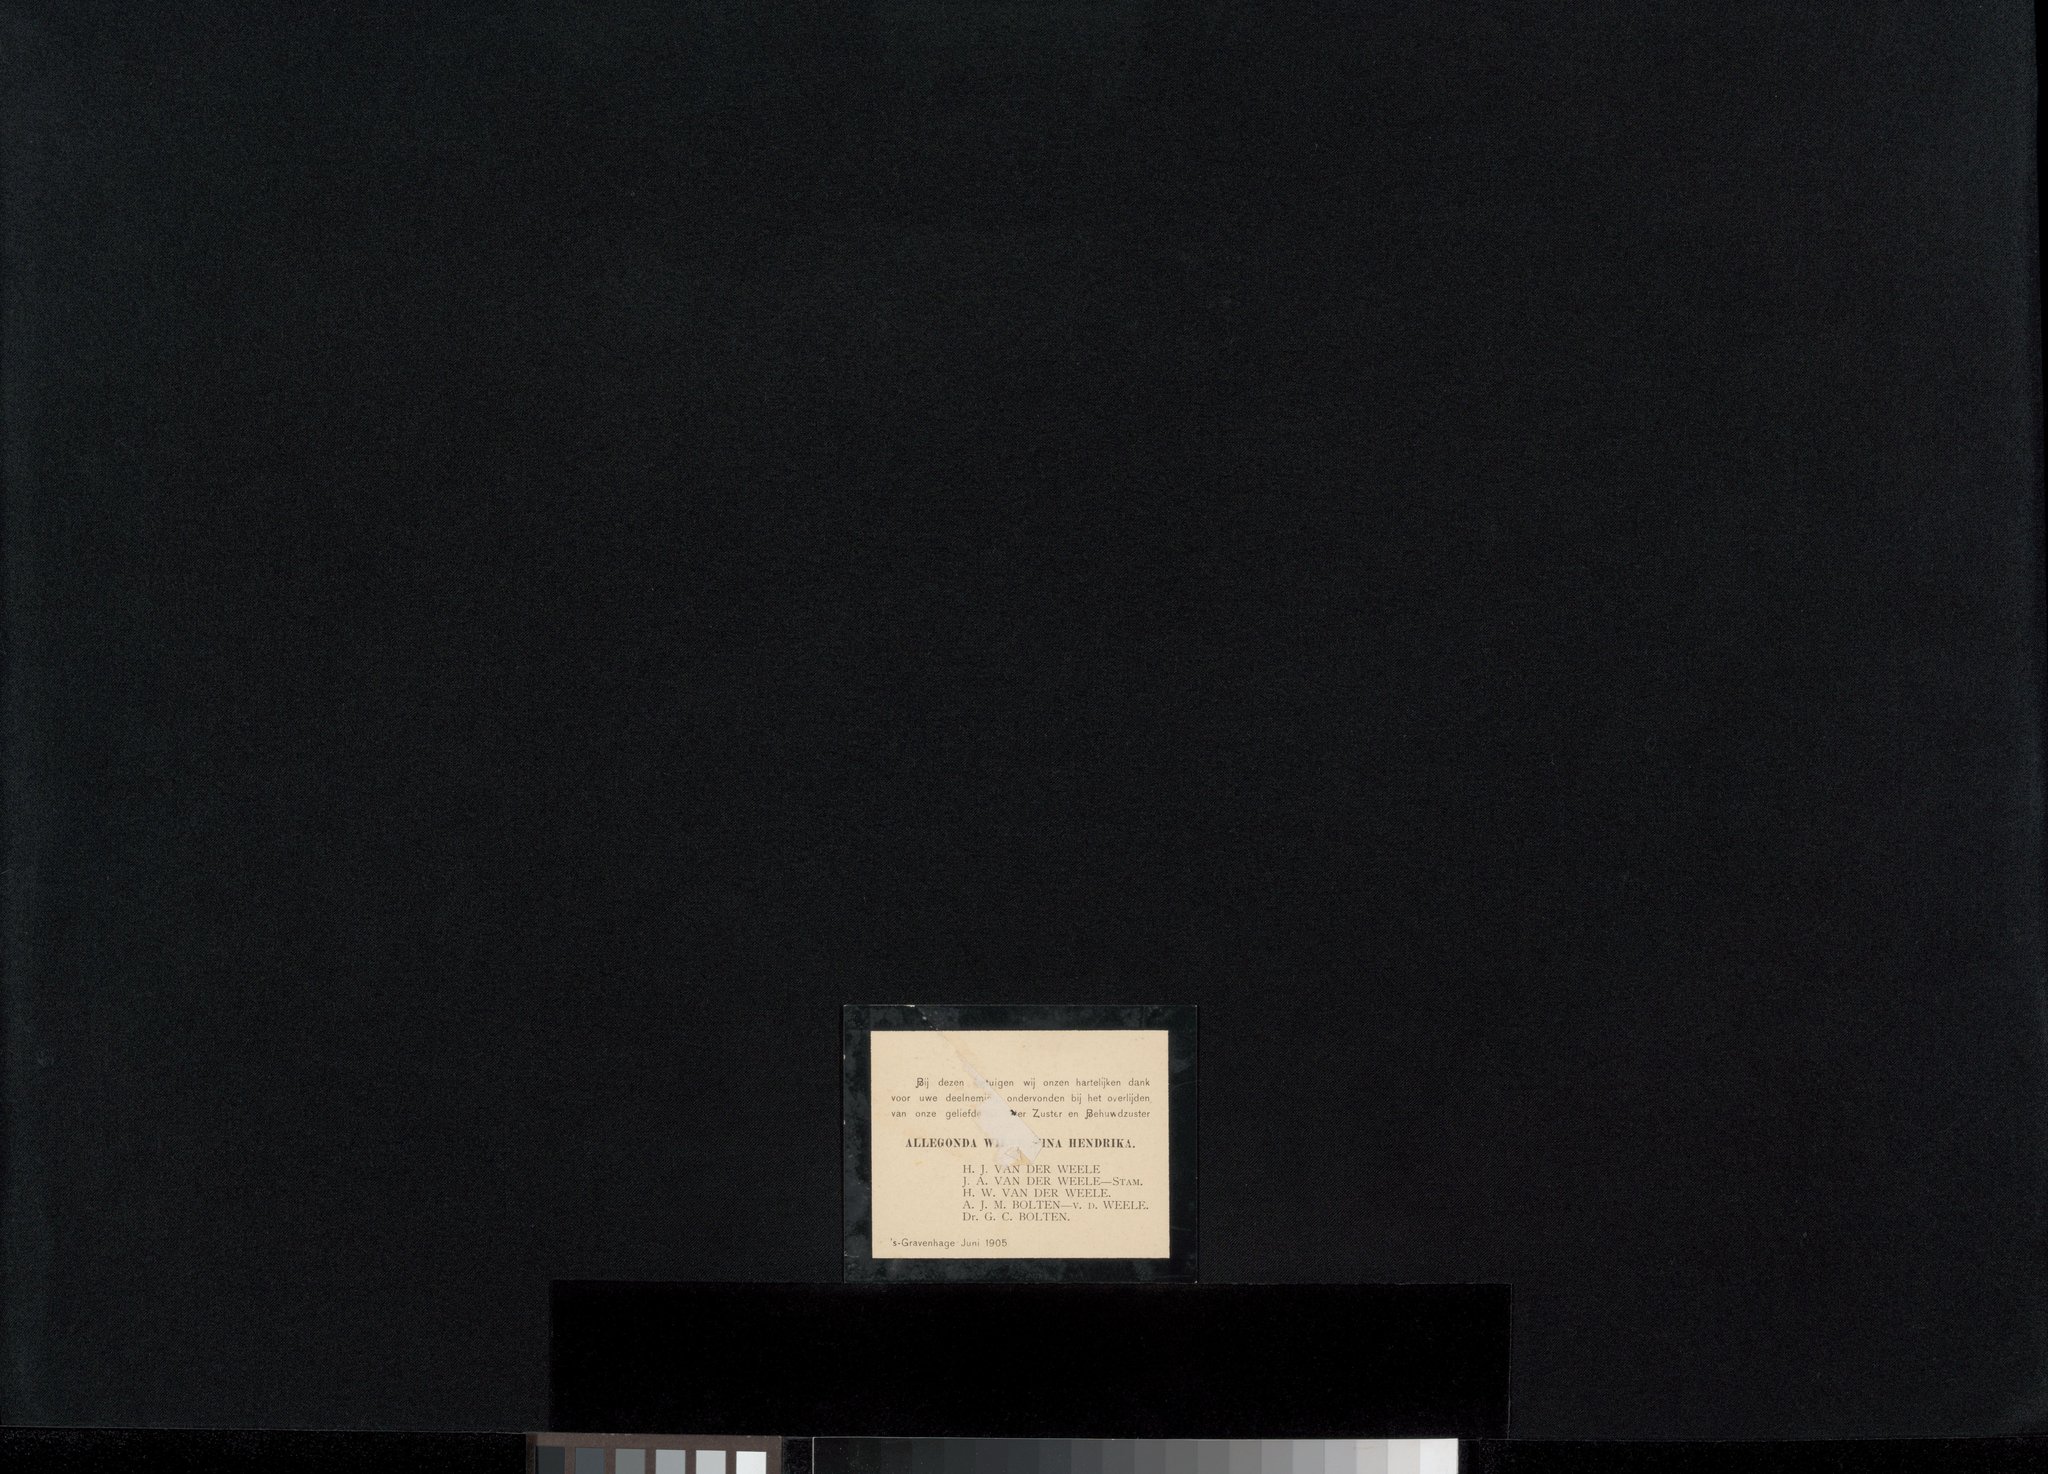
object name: bedankkaart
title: Bedankkaart aan Philip Zilcken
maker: Anonymous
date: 1905-1906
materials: cardboard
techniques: printing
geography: the hague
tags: middelburg, print maker, herman johannes van der weele, the hague, painter, draughtsman, philip zilcken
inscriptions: collector's mark: ‘RPK’